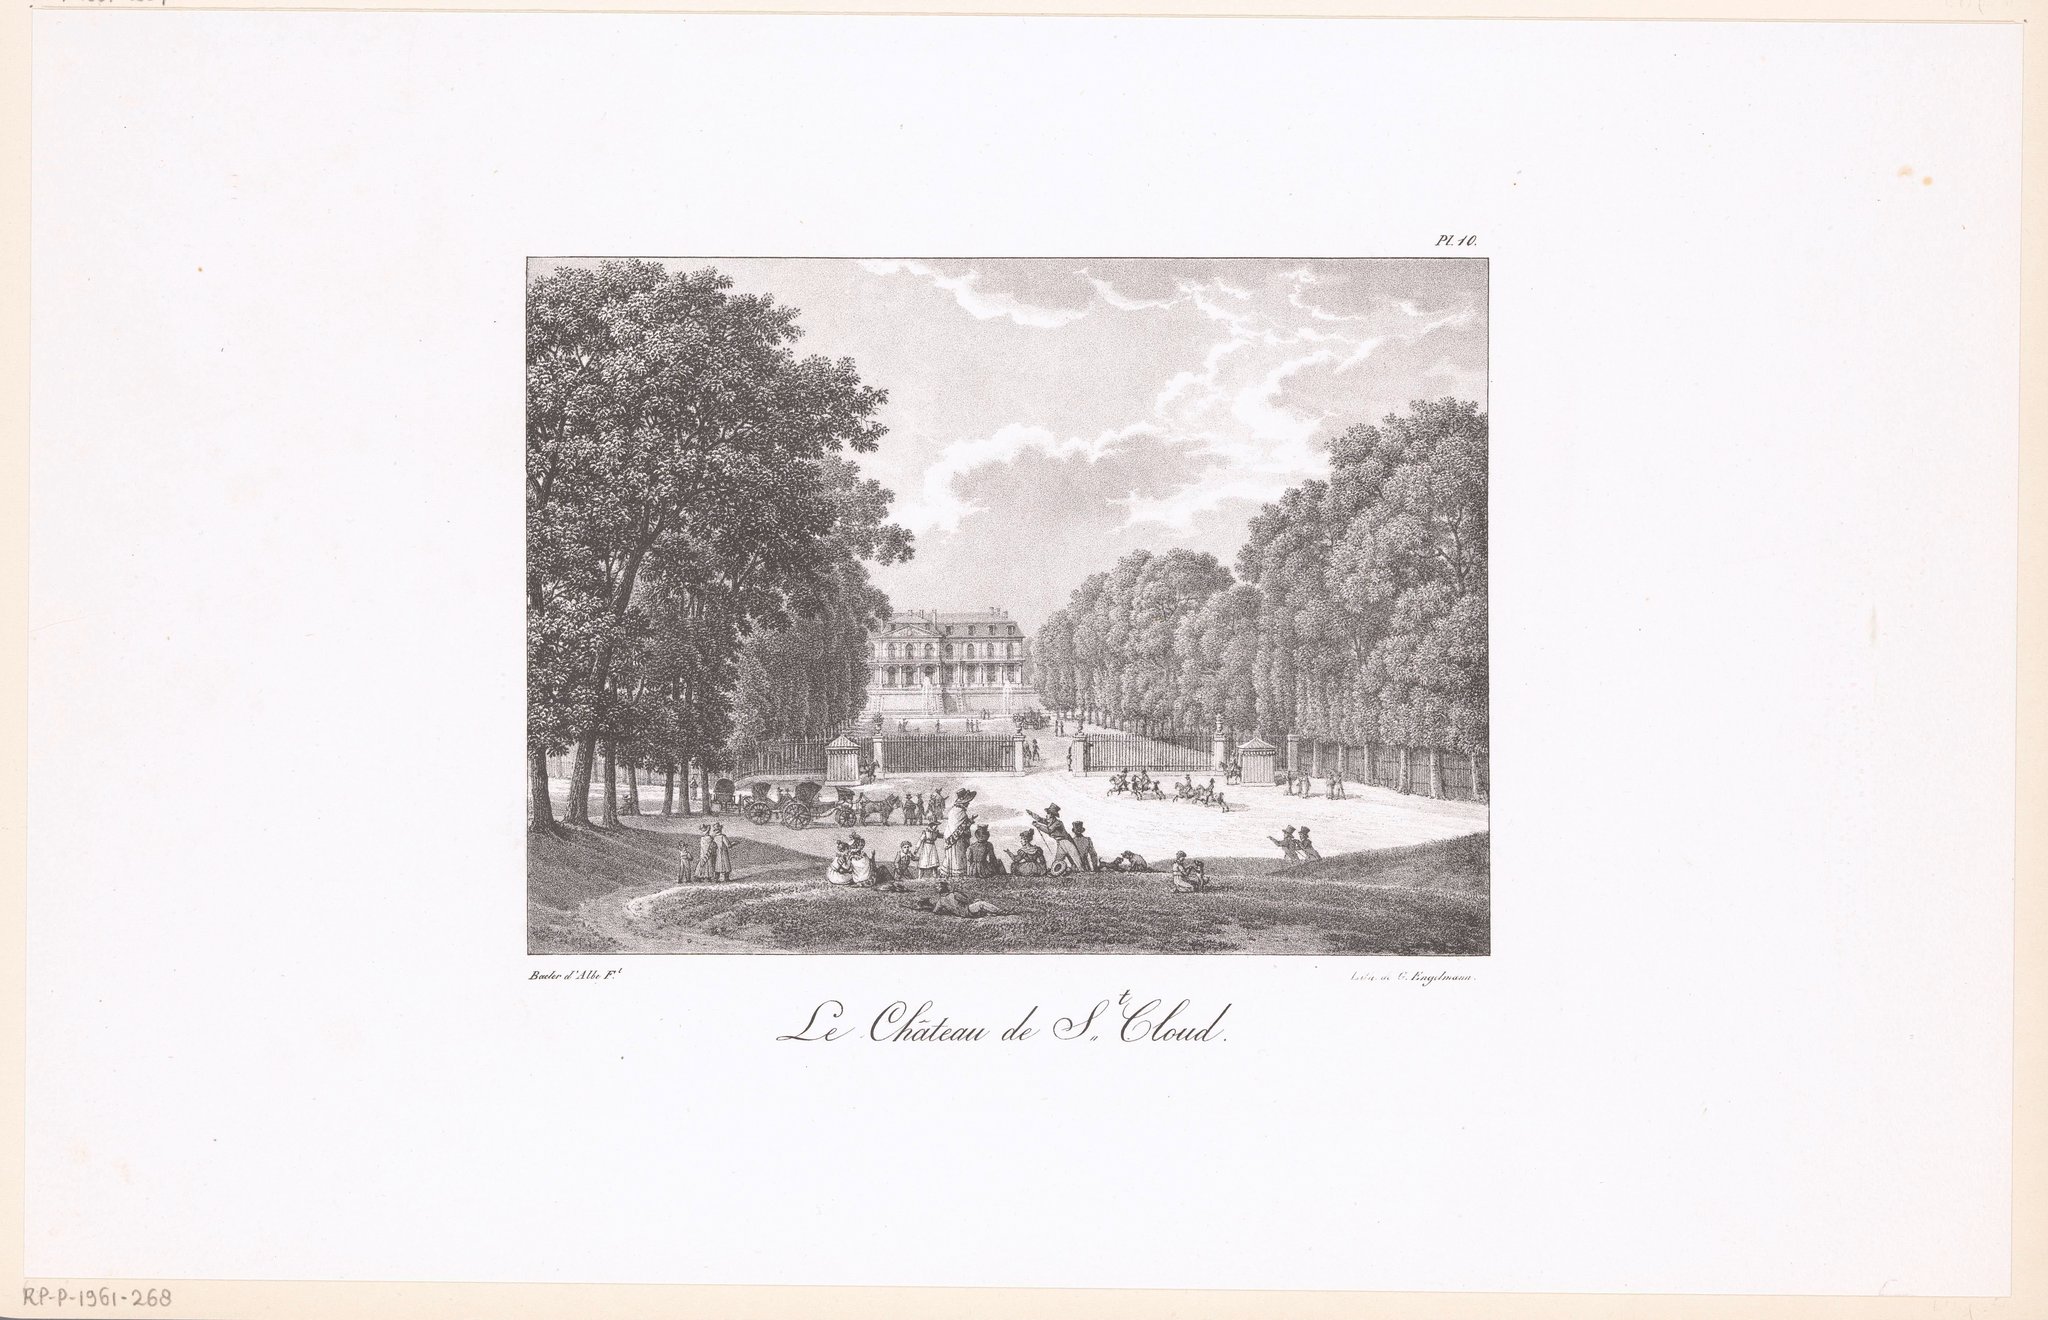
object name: print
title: Le Château de St. Cloud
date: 1822-1824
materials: paper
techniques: lithograph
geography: paris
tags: castle, palace, public gardens, park